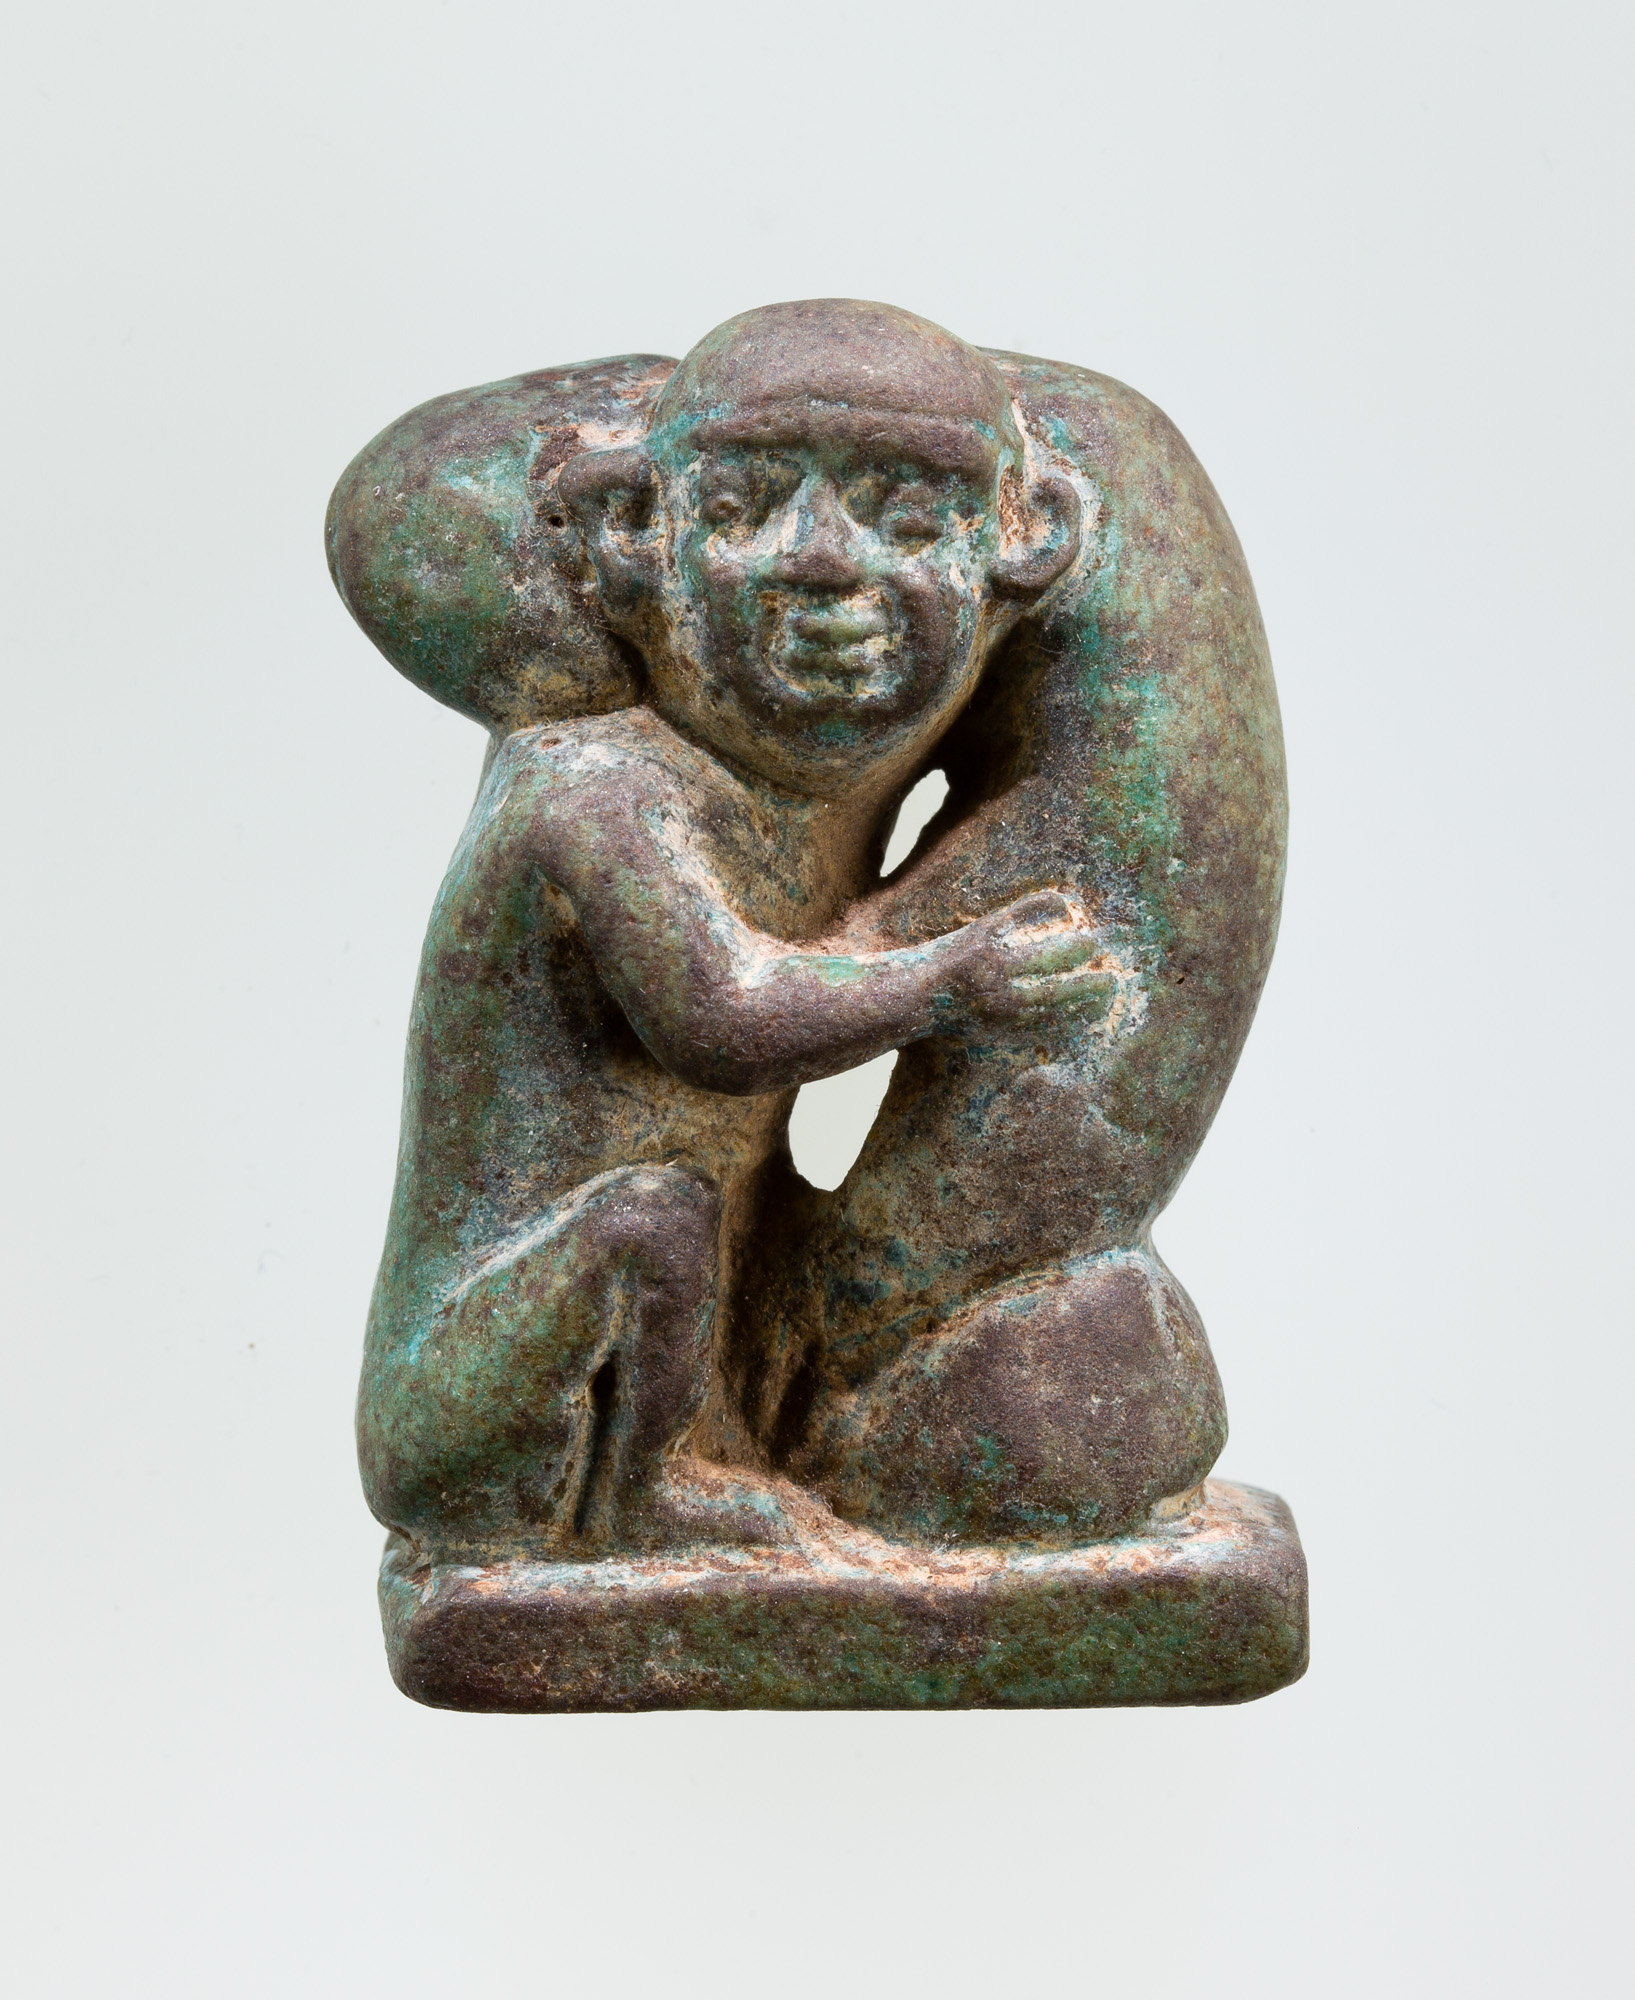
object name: statuette, erotic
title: Erotic figurine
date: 600-300 BCE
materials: faience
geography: egypt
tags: men